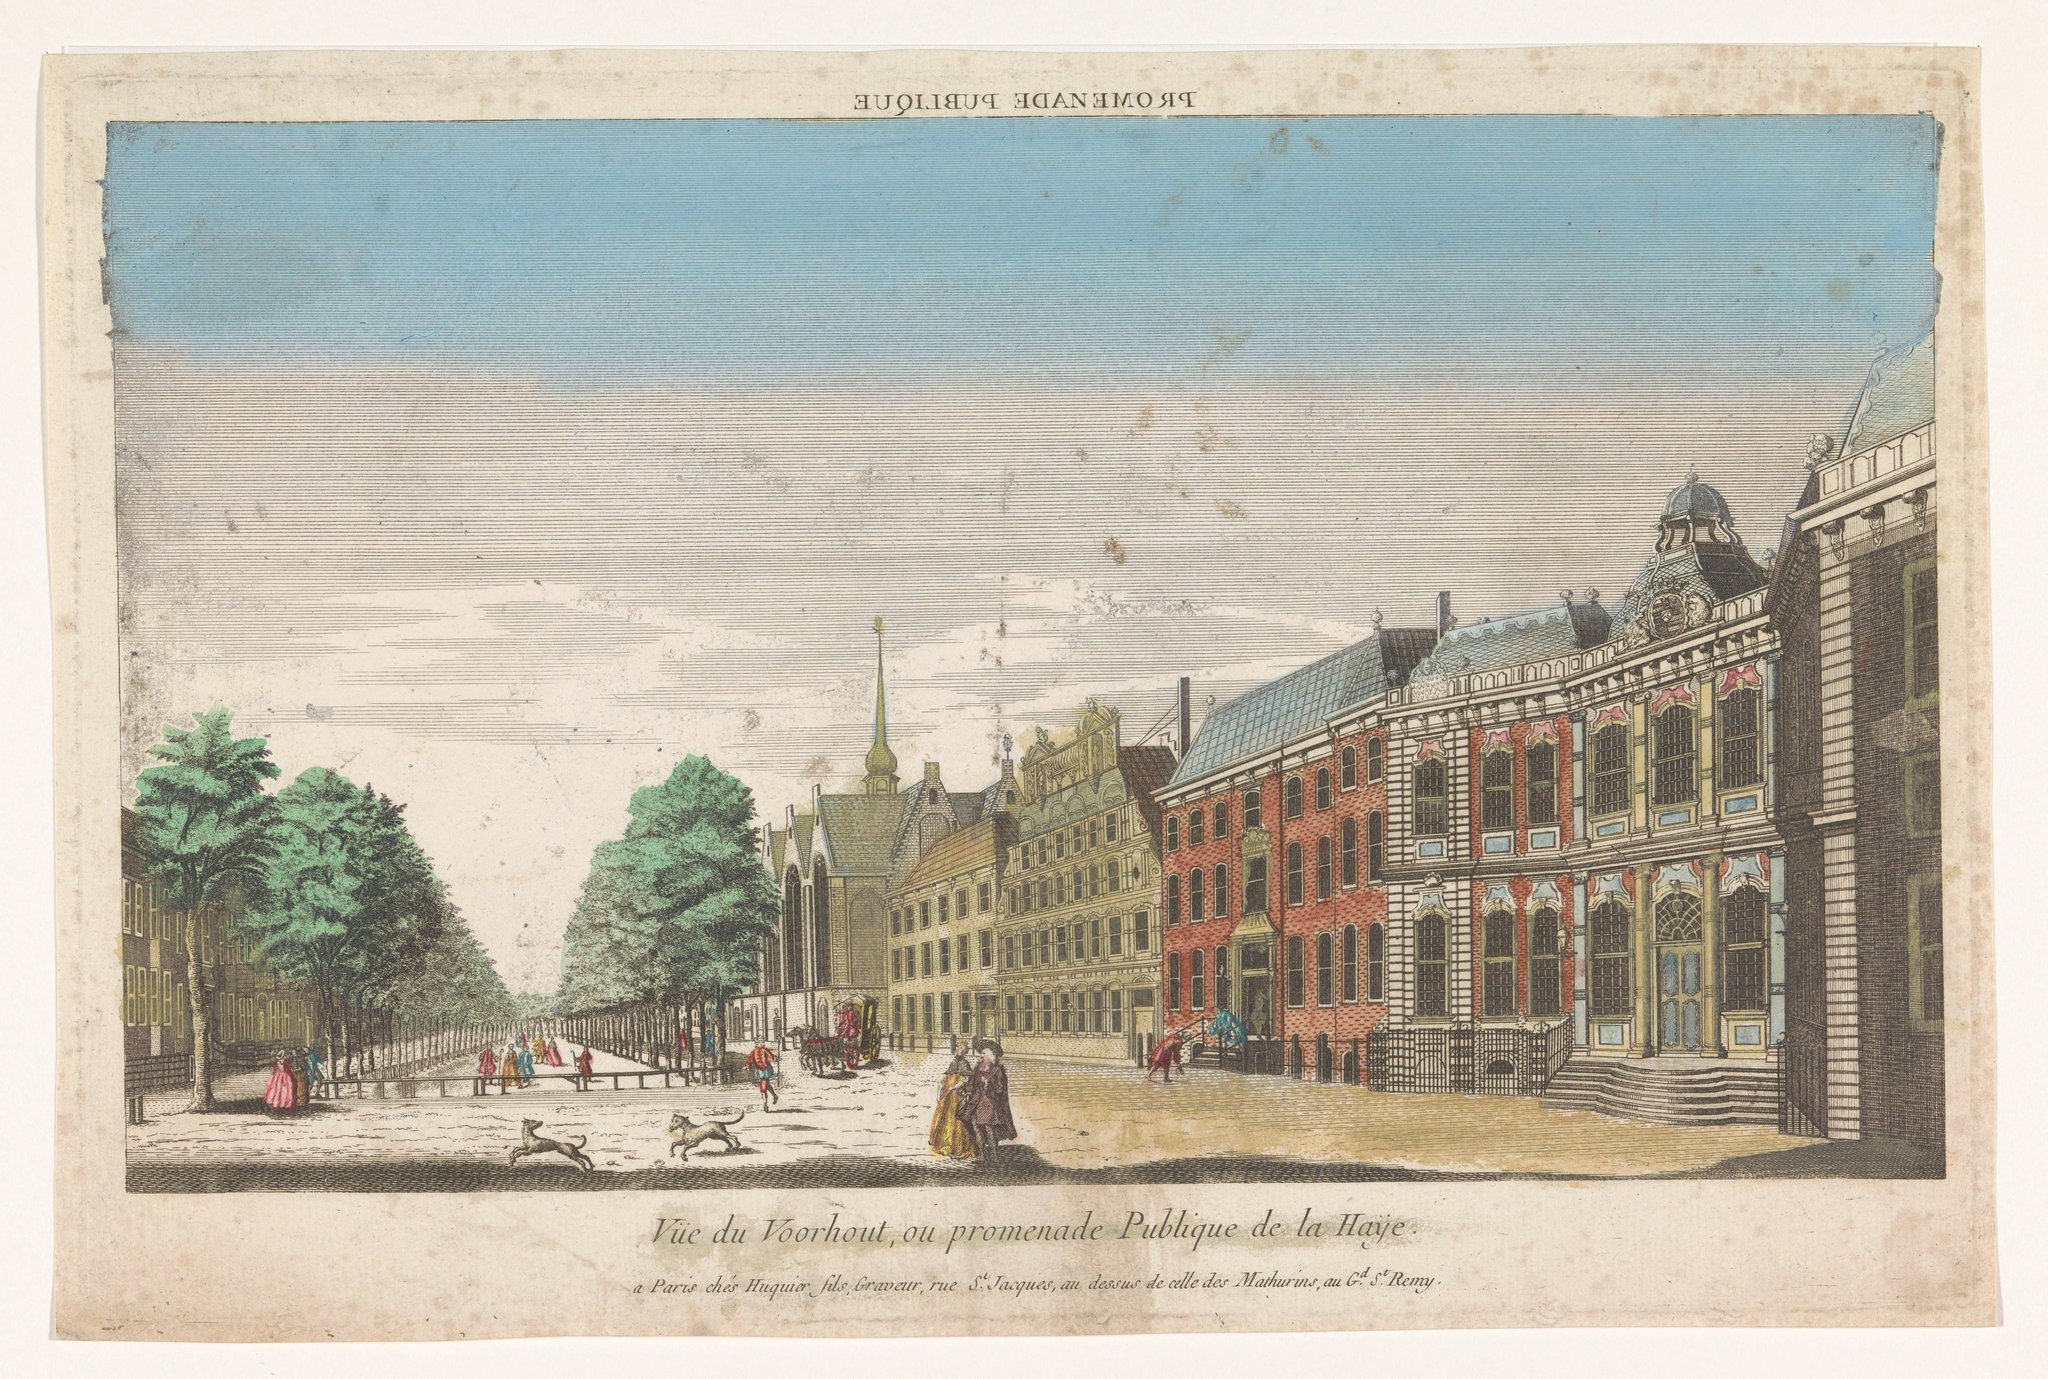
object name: opticaprent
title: Promenade publique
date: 1735-1805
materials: paper, watercolor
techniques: brush, etching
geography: paris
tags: church (exterior), street (+ city(-scape) with figures, staffage)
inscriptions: watermark, collector's mark: Lugt 2233